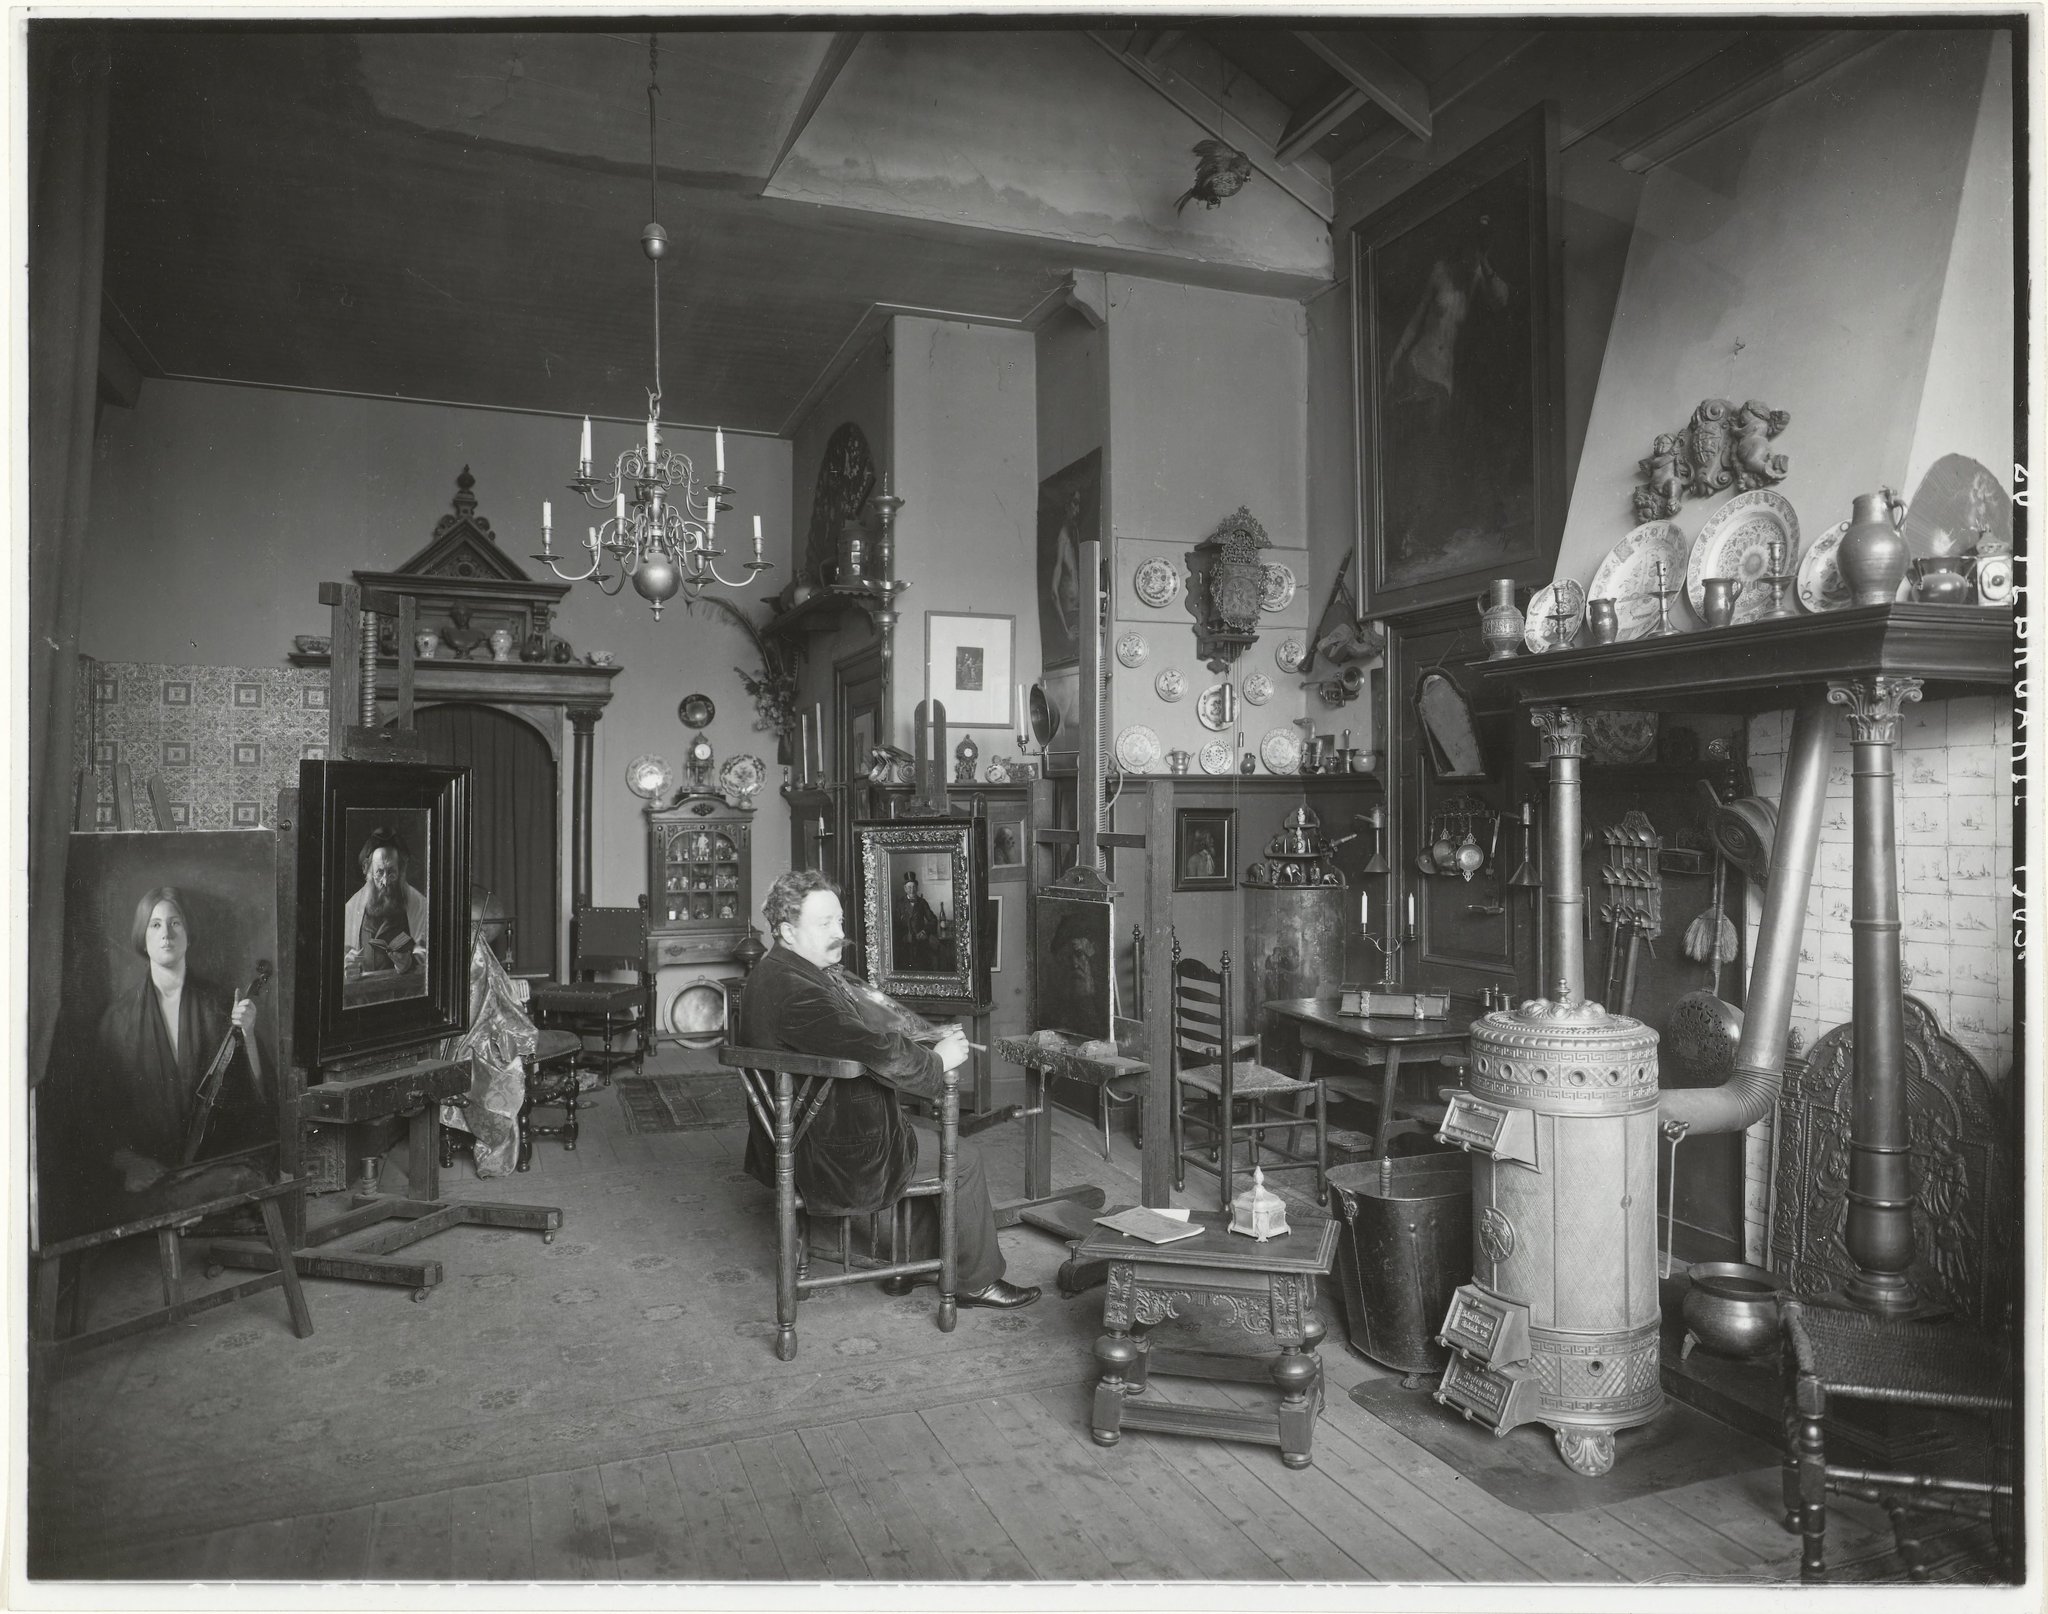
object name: photograph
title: Kunstenaar Benjamin Prins in zijn atelier in de Plantage Franselaan 25 in Amsterdam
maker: sigmund löw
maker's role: publisher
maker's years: 1845-1920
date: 1903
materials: paper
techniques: gelatin silver print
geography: amsterdam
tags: arnhem, painter, benjamin liepman prins, painter at work, in his studio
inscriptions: inscription: ‘Benj. Prins Plantage Franselaan 25 Amsterdam’, copyright notice: ‘World Copyright by W.M.A. Deppe, Bachlaan, 1 Naarden (Holland) telef. K 2959-5505’, date: ‘20 FEBRUARI 1903’